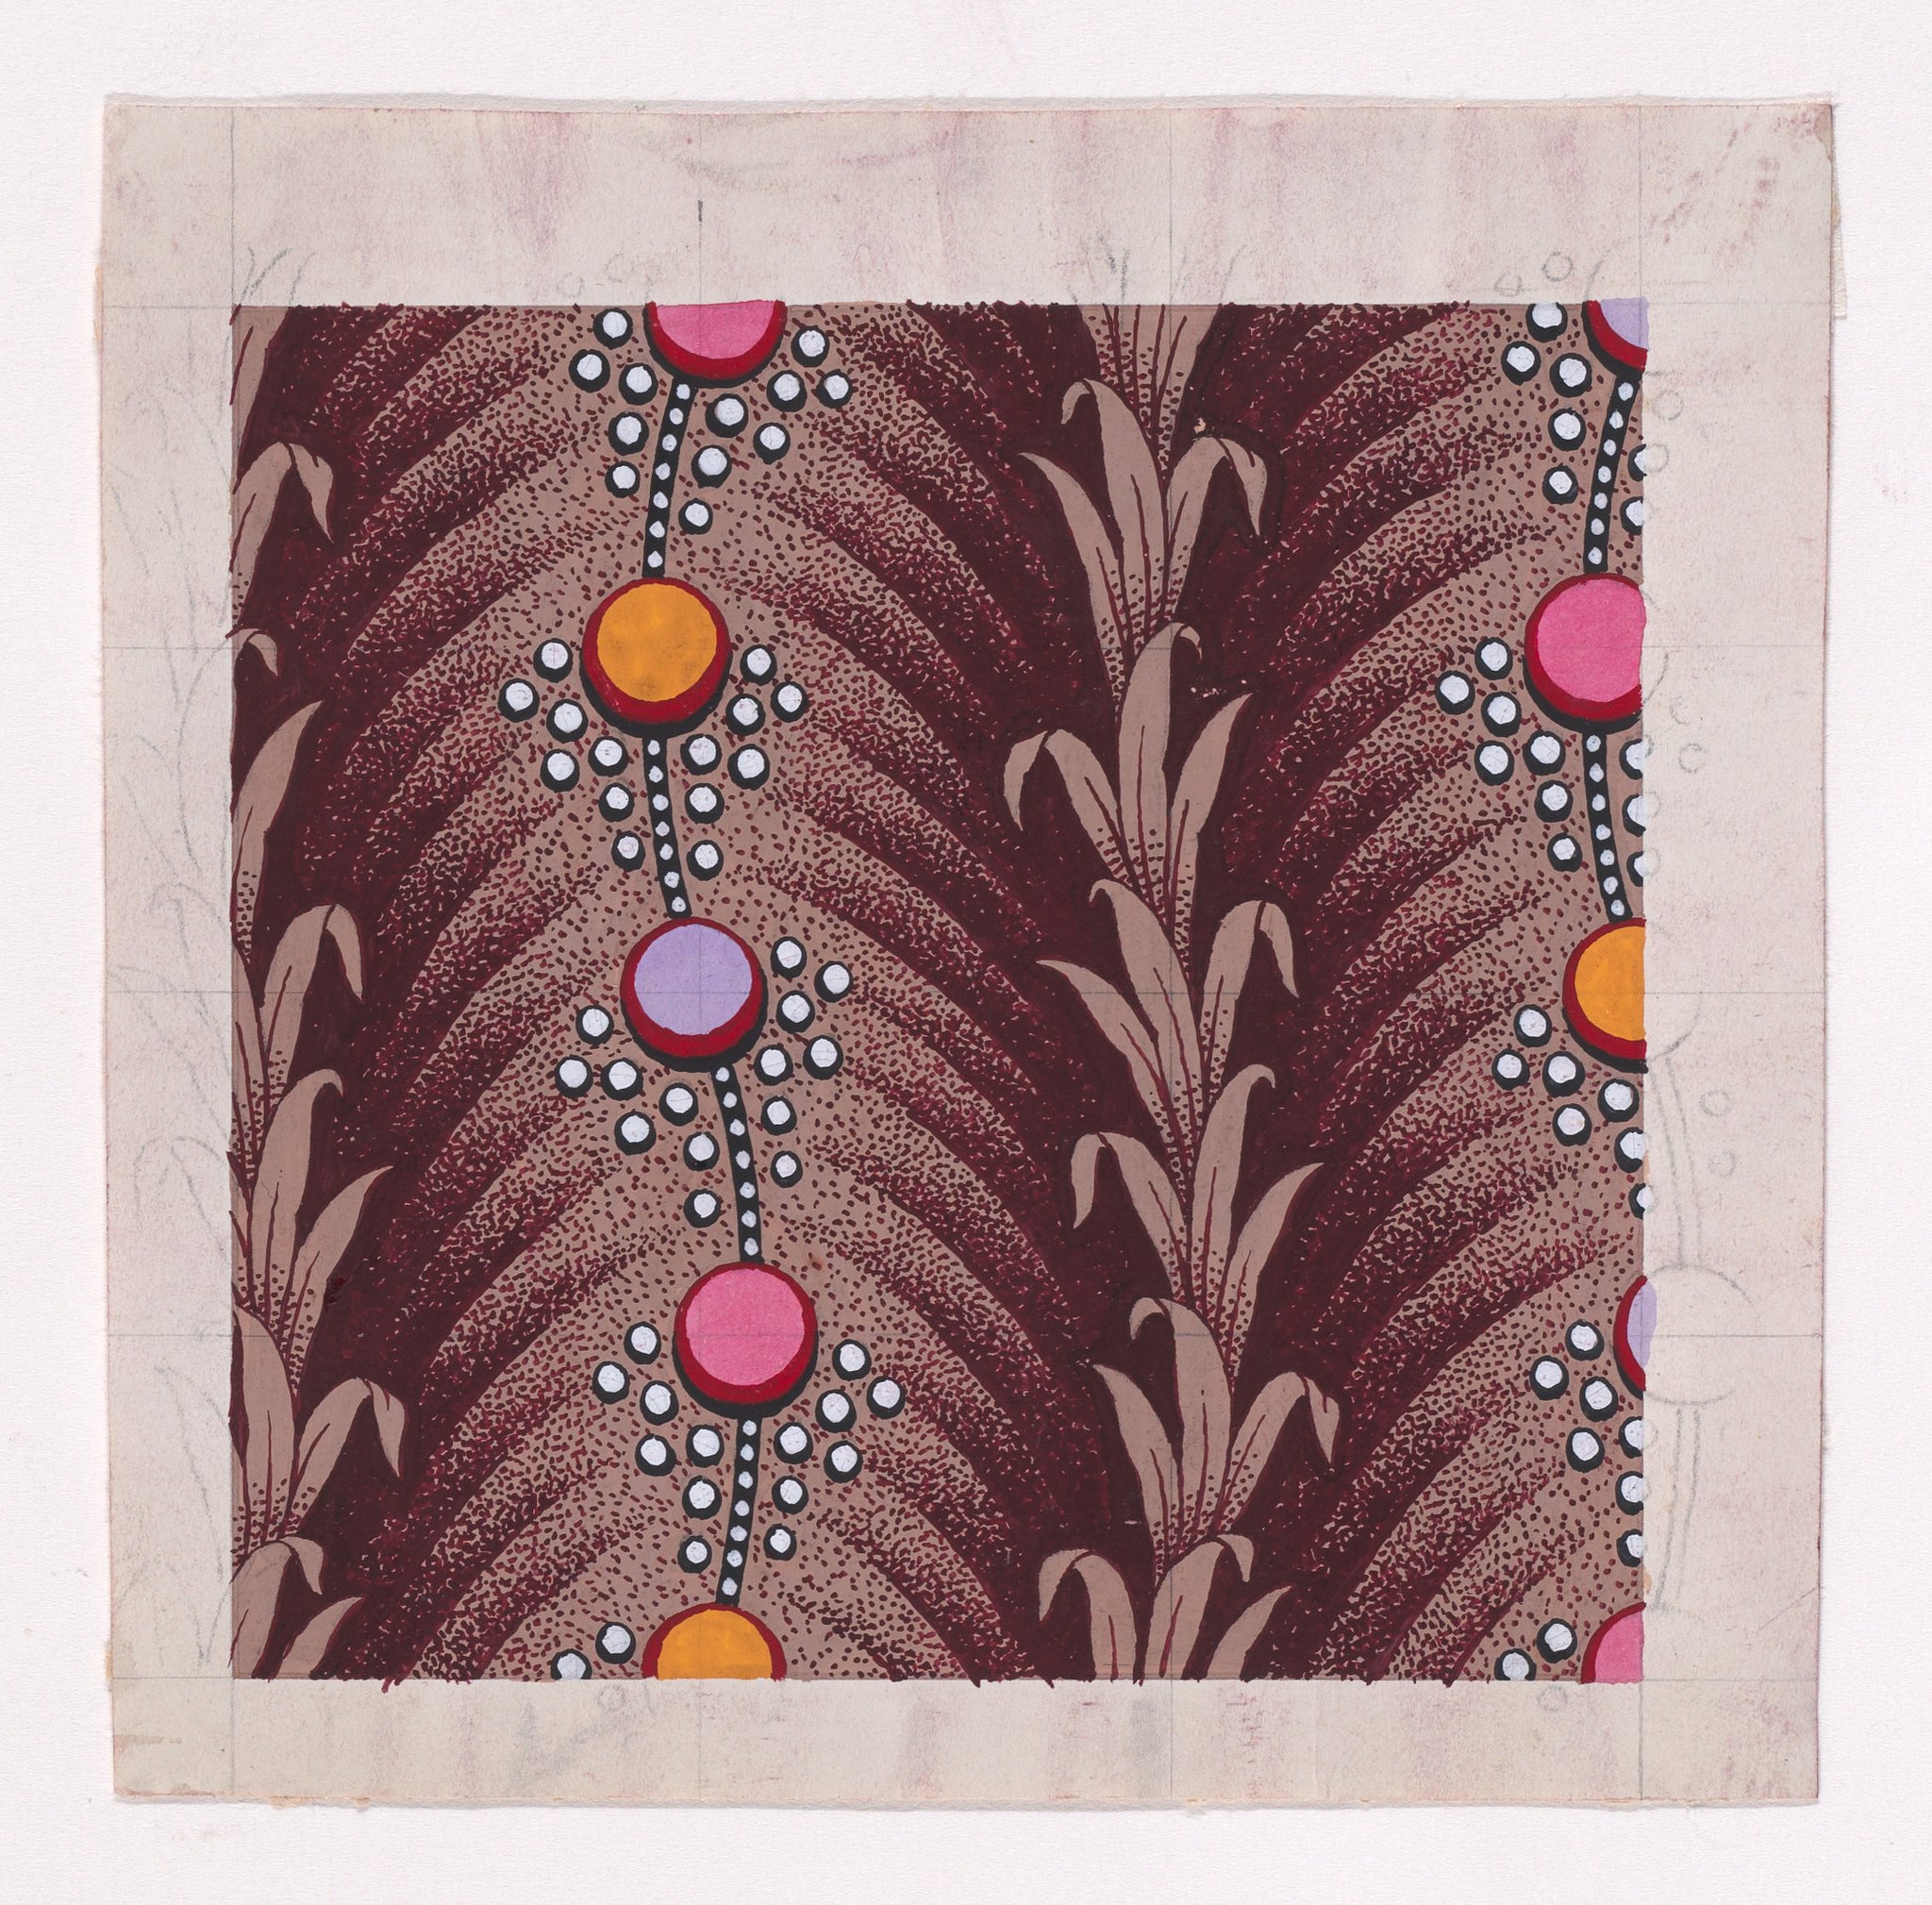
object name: drawing ornament architecture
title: Textile Design with Alternating Vertical Garland of Stylized Leaves and Undulating Circles Surrounded by Pearls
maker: anonymous, alsatian, 19th century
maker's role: artist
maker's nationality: alsatian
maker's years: 1800-1900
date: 1840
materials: gouache